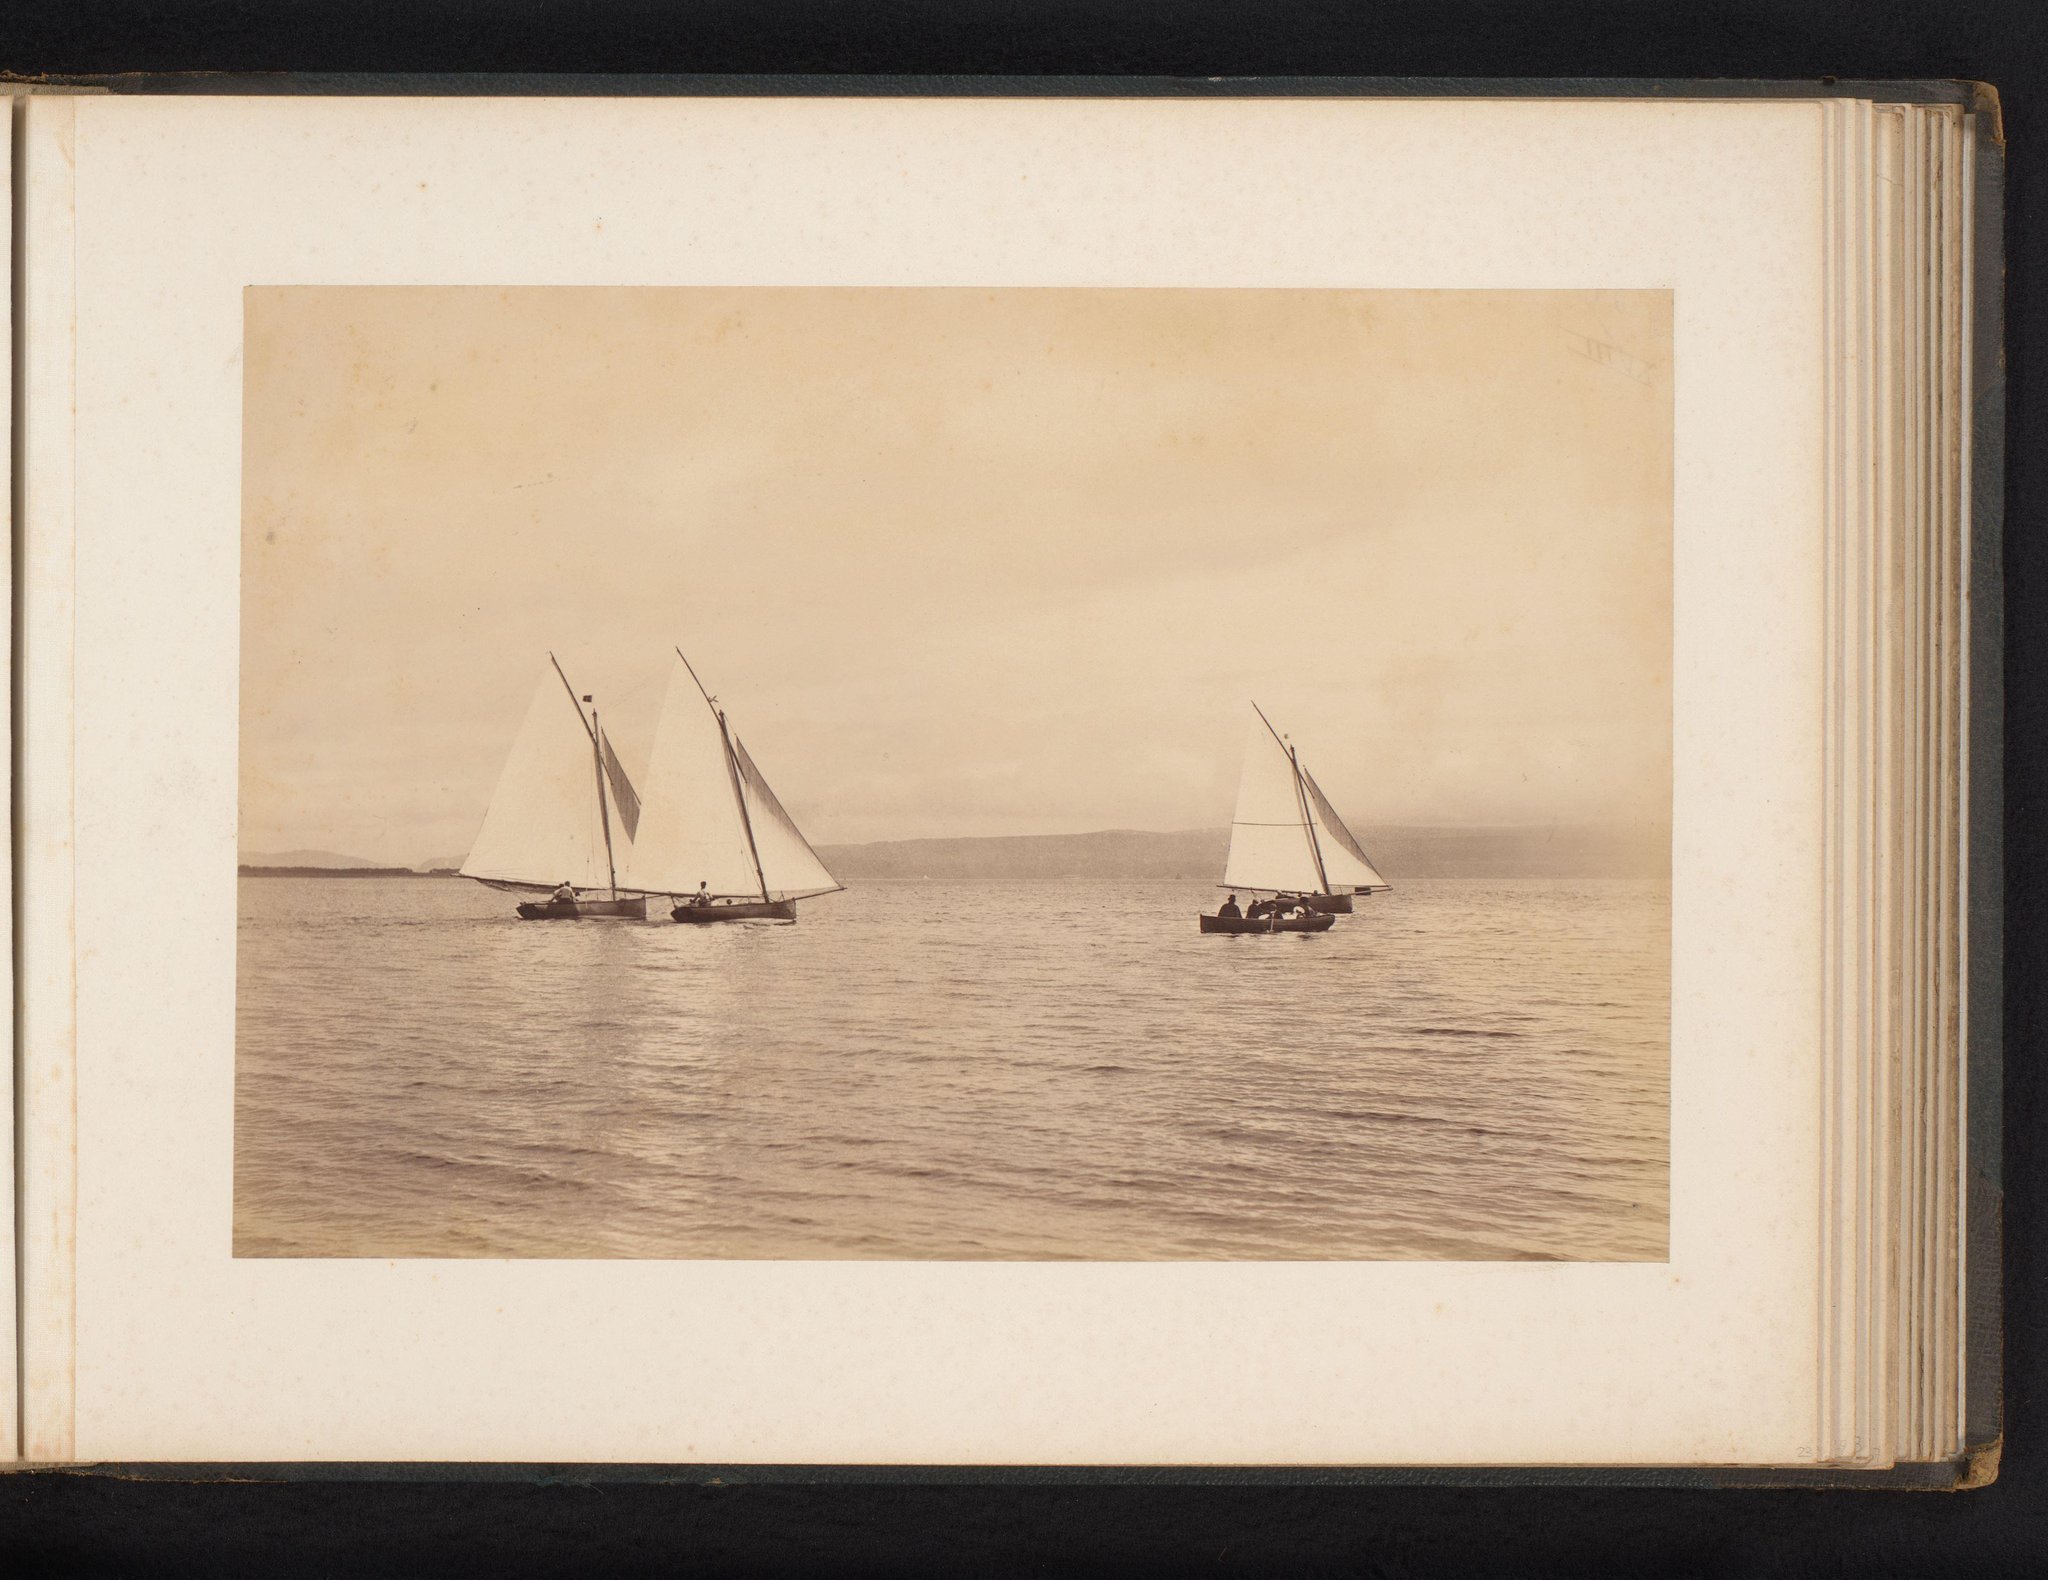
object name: album leaf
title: Zeilschepen Harlequin, Astore en Sally te water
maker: james adamson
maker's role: fotograaf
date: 1880-1900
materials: photographic support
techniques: albumen print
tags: sailing-ship, sailing-boat, landscapes with waters, waterscapes, seascapes (in the temperate zone)